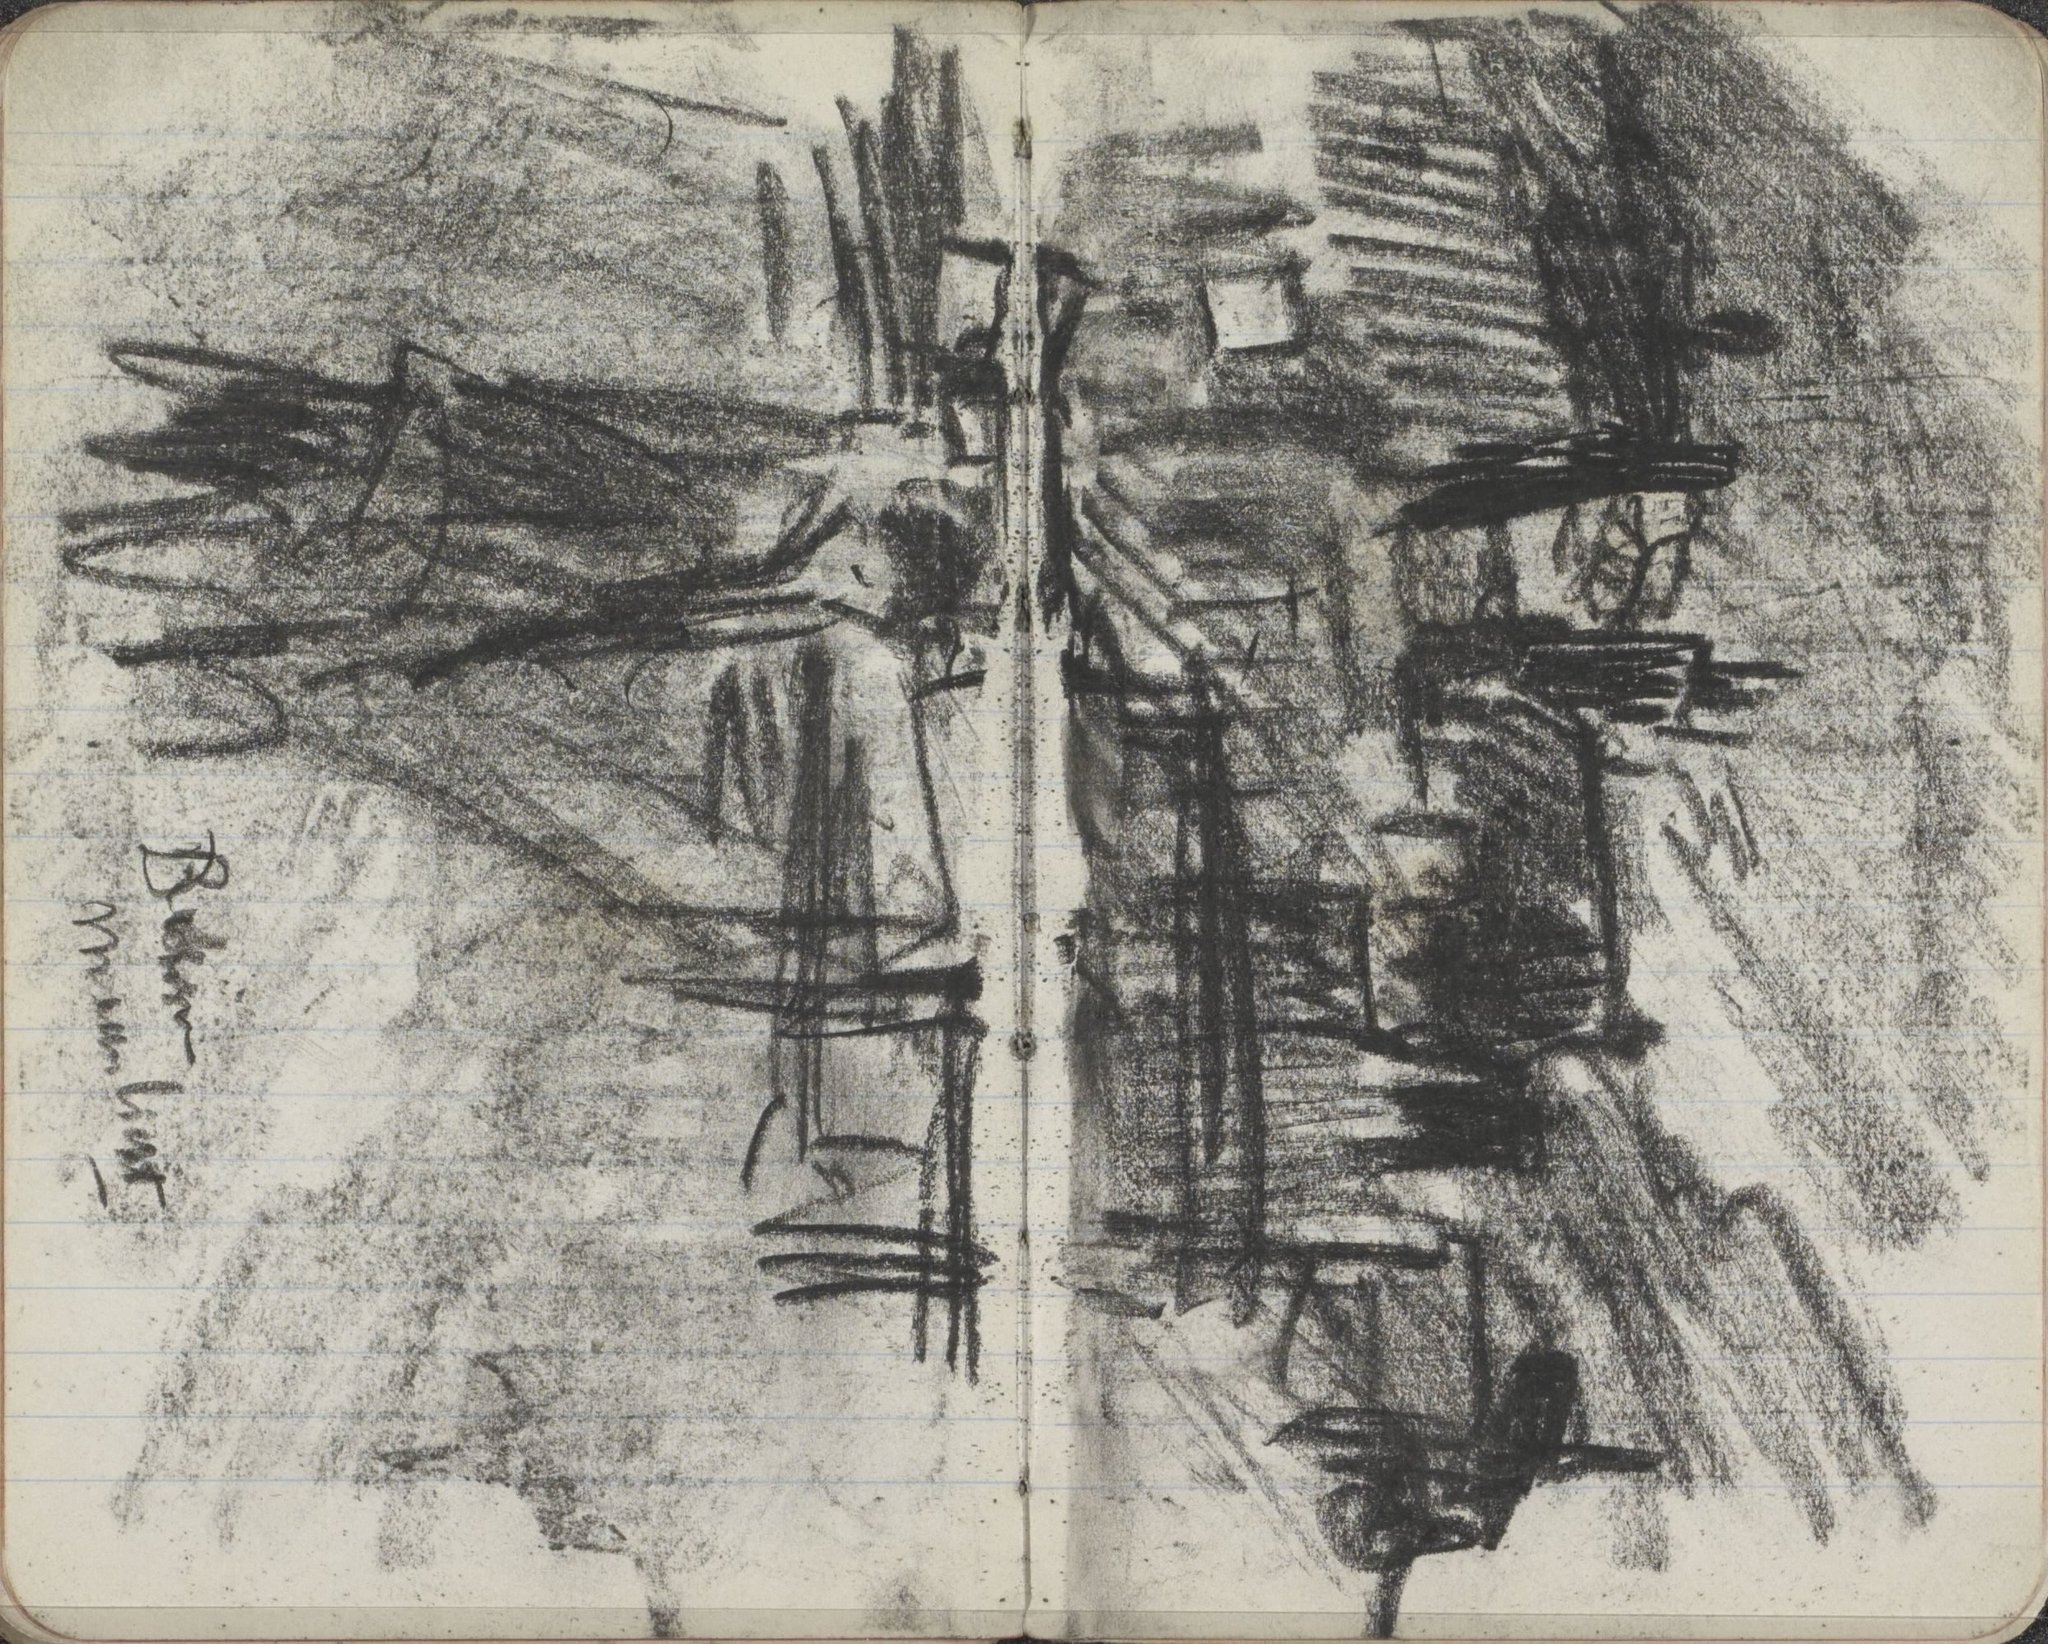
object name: sketchbook leaf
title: Gezicht op het Rokin te Amsterdam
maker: george hendrik breitner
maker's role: draughtsman, painter, print maker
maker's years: 1857-1923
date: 1893-1898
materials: chalk, paper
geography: amsterdam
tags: canals, waters (in city), civic architecture; edifices; dwellings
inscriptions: annotation: ‘Rokin/ maanlicht’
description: Vooraan een vrouw. Pagina 65 en pagina 66 uit een schetsboek met 38 bladen.